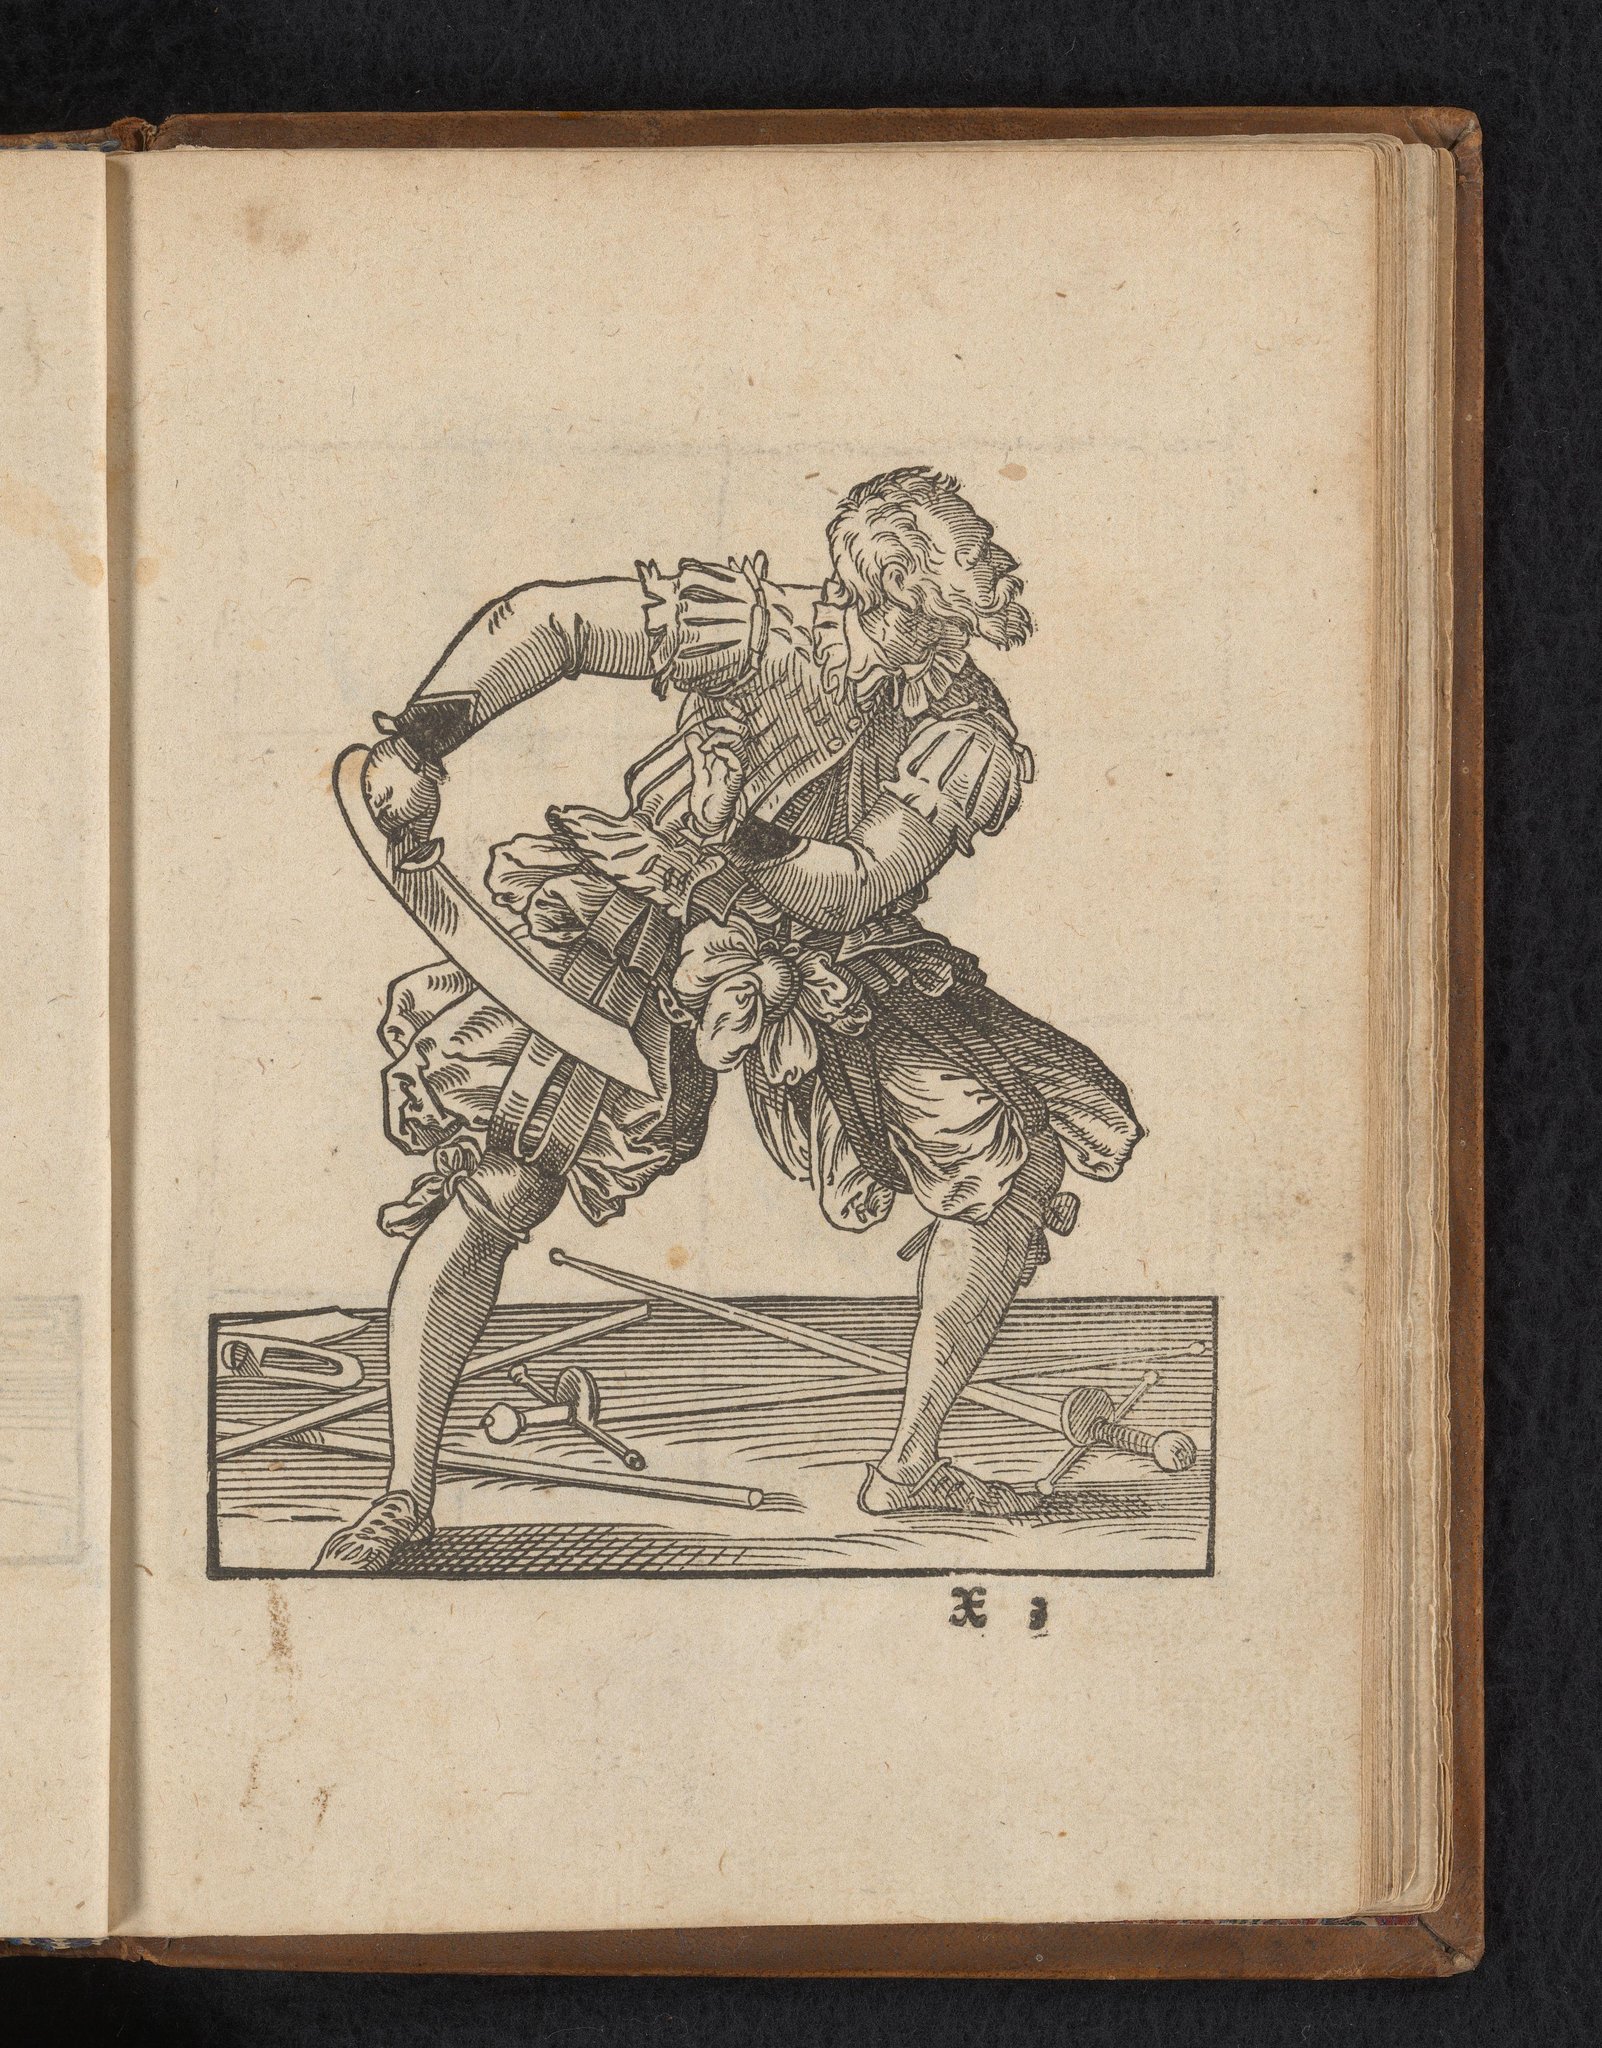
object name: print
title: Wapenoefening met een slagzwaard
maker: Anonymous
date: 1578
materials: paper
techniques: woodcut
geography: nuremberg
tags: handling of weapons ~ military training (+ infantry)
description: Wapenoefening met een slagzwaard, naar rechts. Onderdeel van het modelboek Enchiridion artis pingendi, fingendi & sculpendi met 108 figuren bedoeld voor beginnende schilders, beeldhouwers en prentmakers.